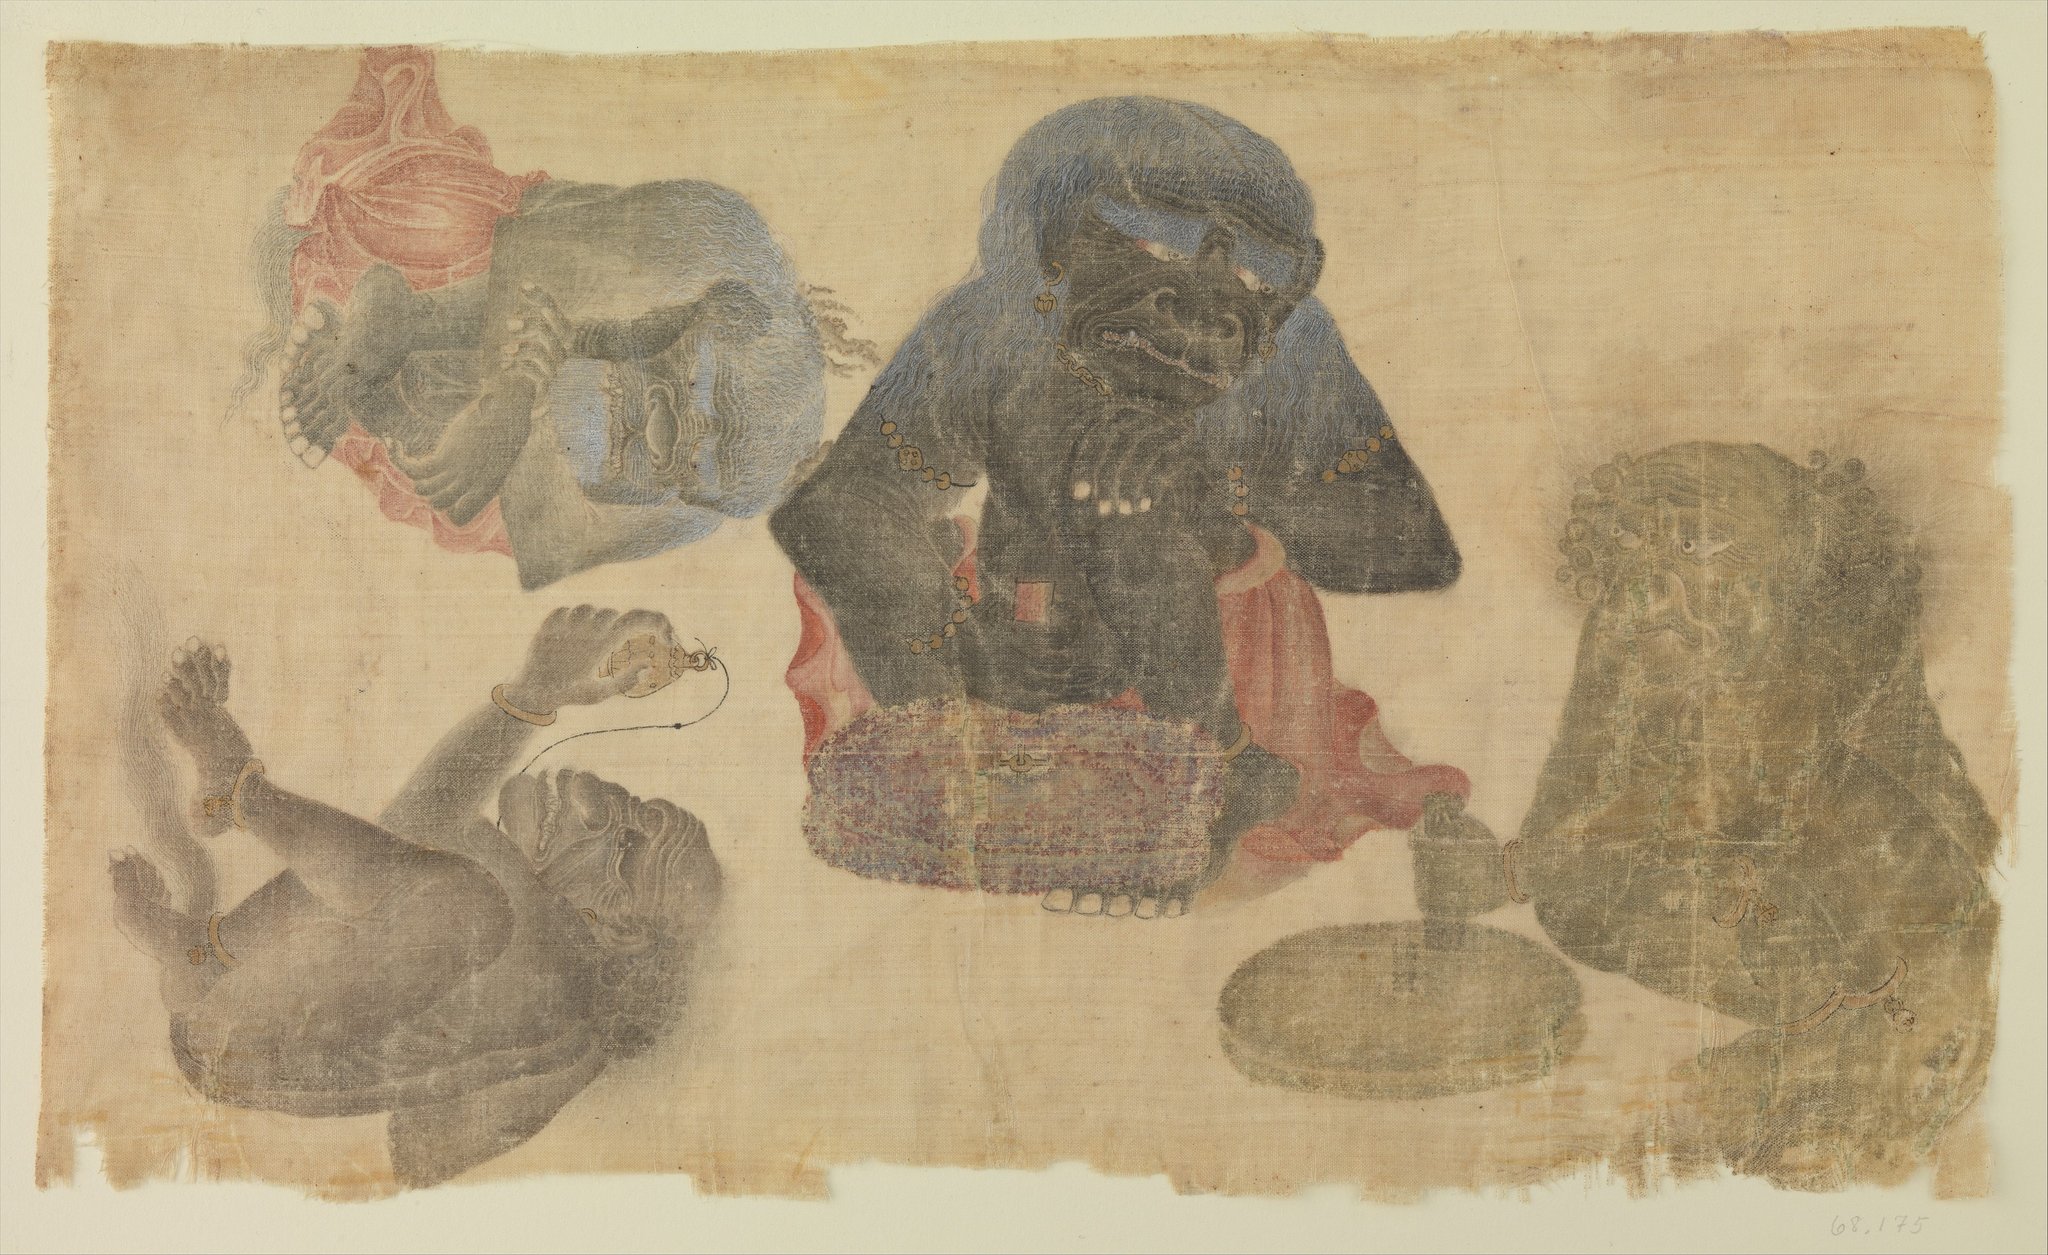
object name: illustrated single work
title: Four Captive Demons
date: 1470-1500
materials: gold, silk, watercolor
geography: iran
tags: demons